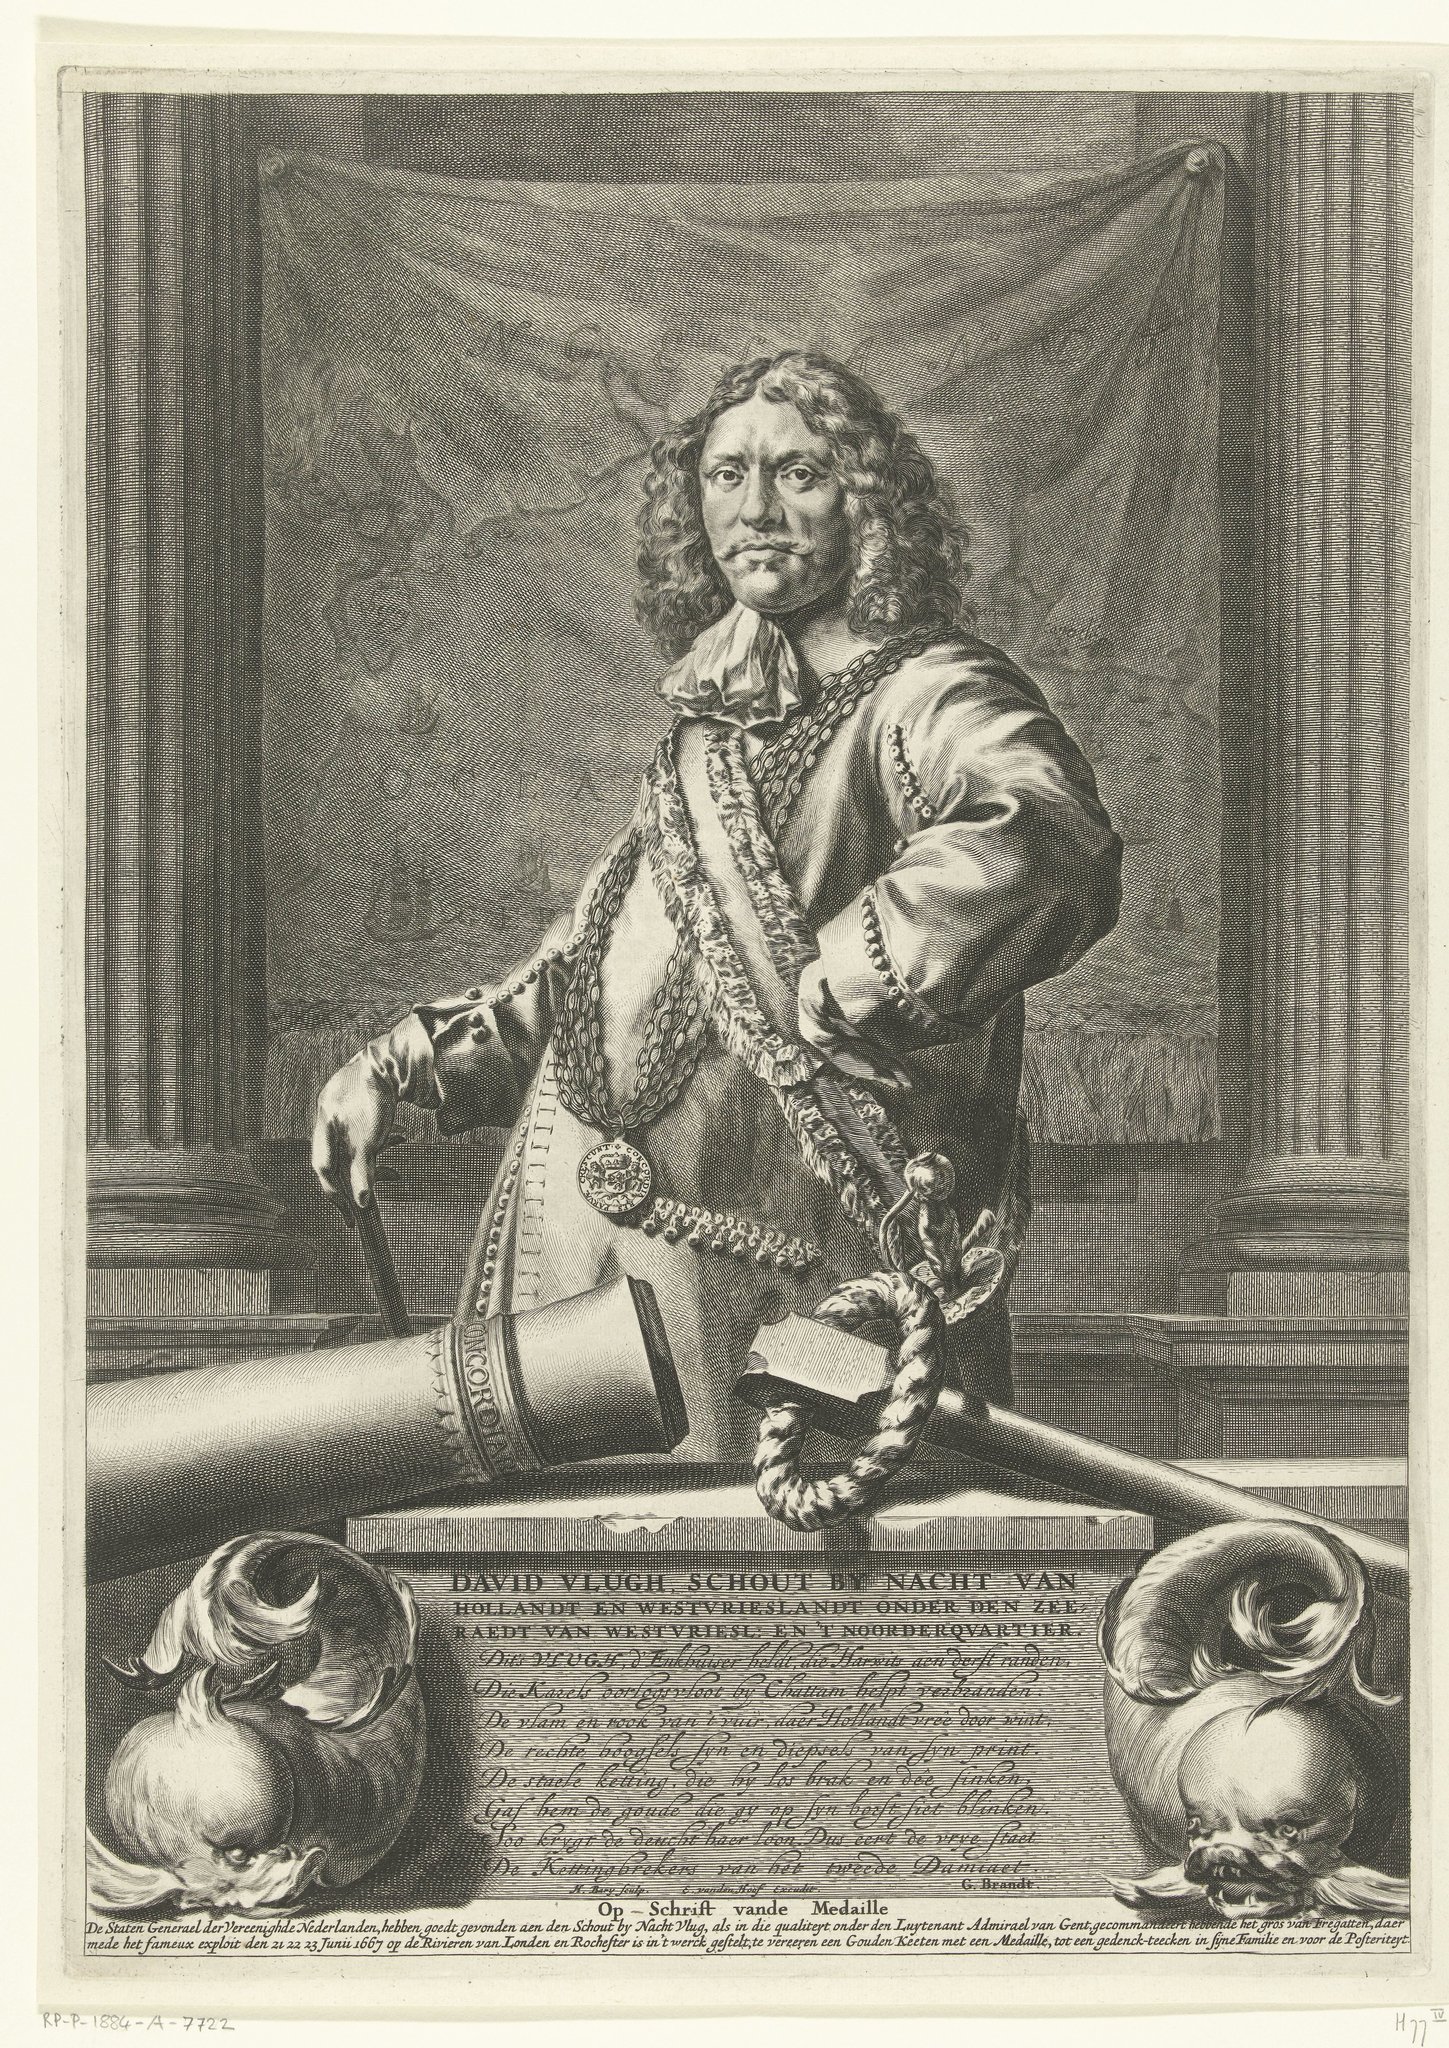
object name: print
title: Portret van David Vlugh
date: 1667-1707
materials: paper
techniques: engraving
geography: netherlands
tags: historical persons, tapestry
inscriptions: collector's mark: Lugt 2228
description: Portret van schout-bij-nacht David Vlugh. Op de achtergrond een wandtapijt met een zeekaart. Met een vers van acht regels in het Nederlands door G. Brandt. Vlugh draagt een medaille aan een ketting om zijn nek. Deze heeft hij ontvangen voor speciale verdiensten, het opschrift van de medaille staat onder de voorstelling.